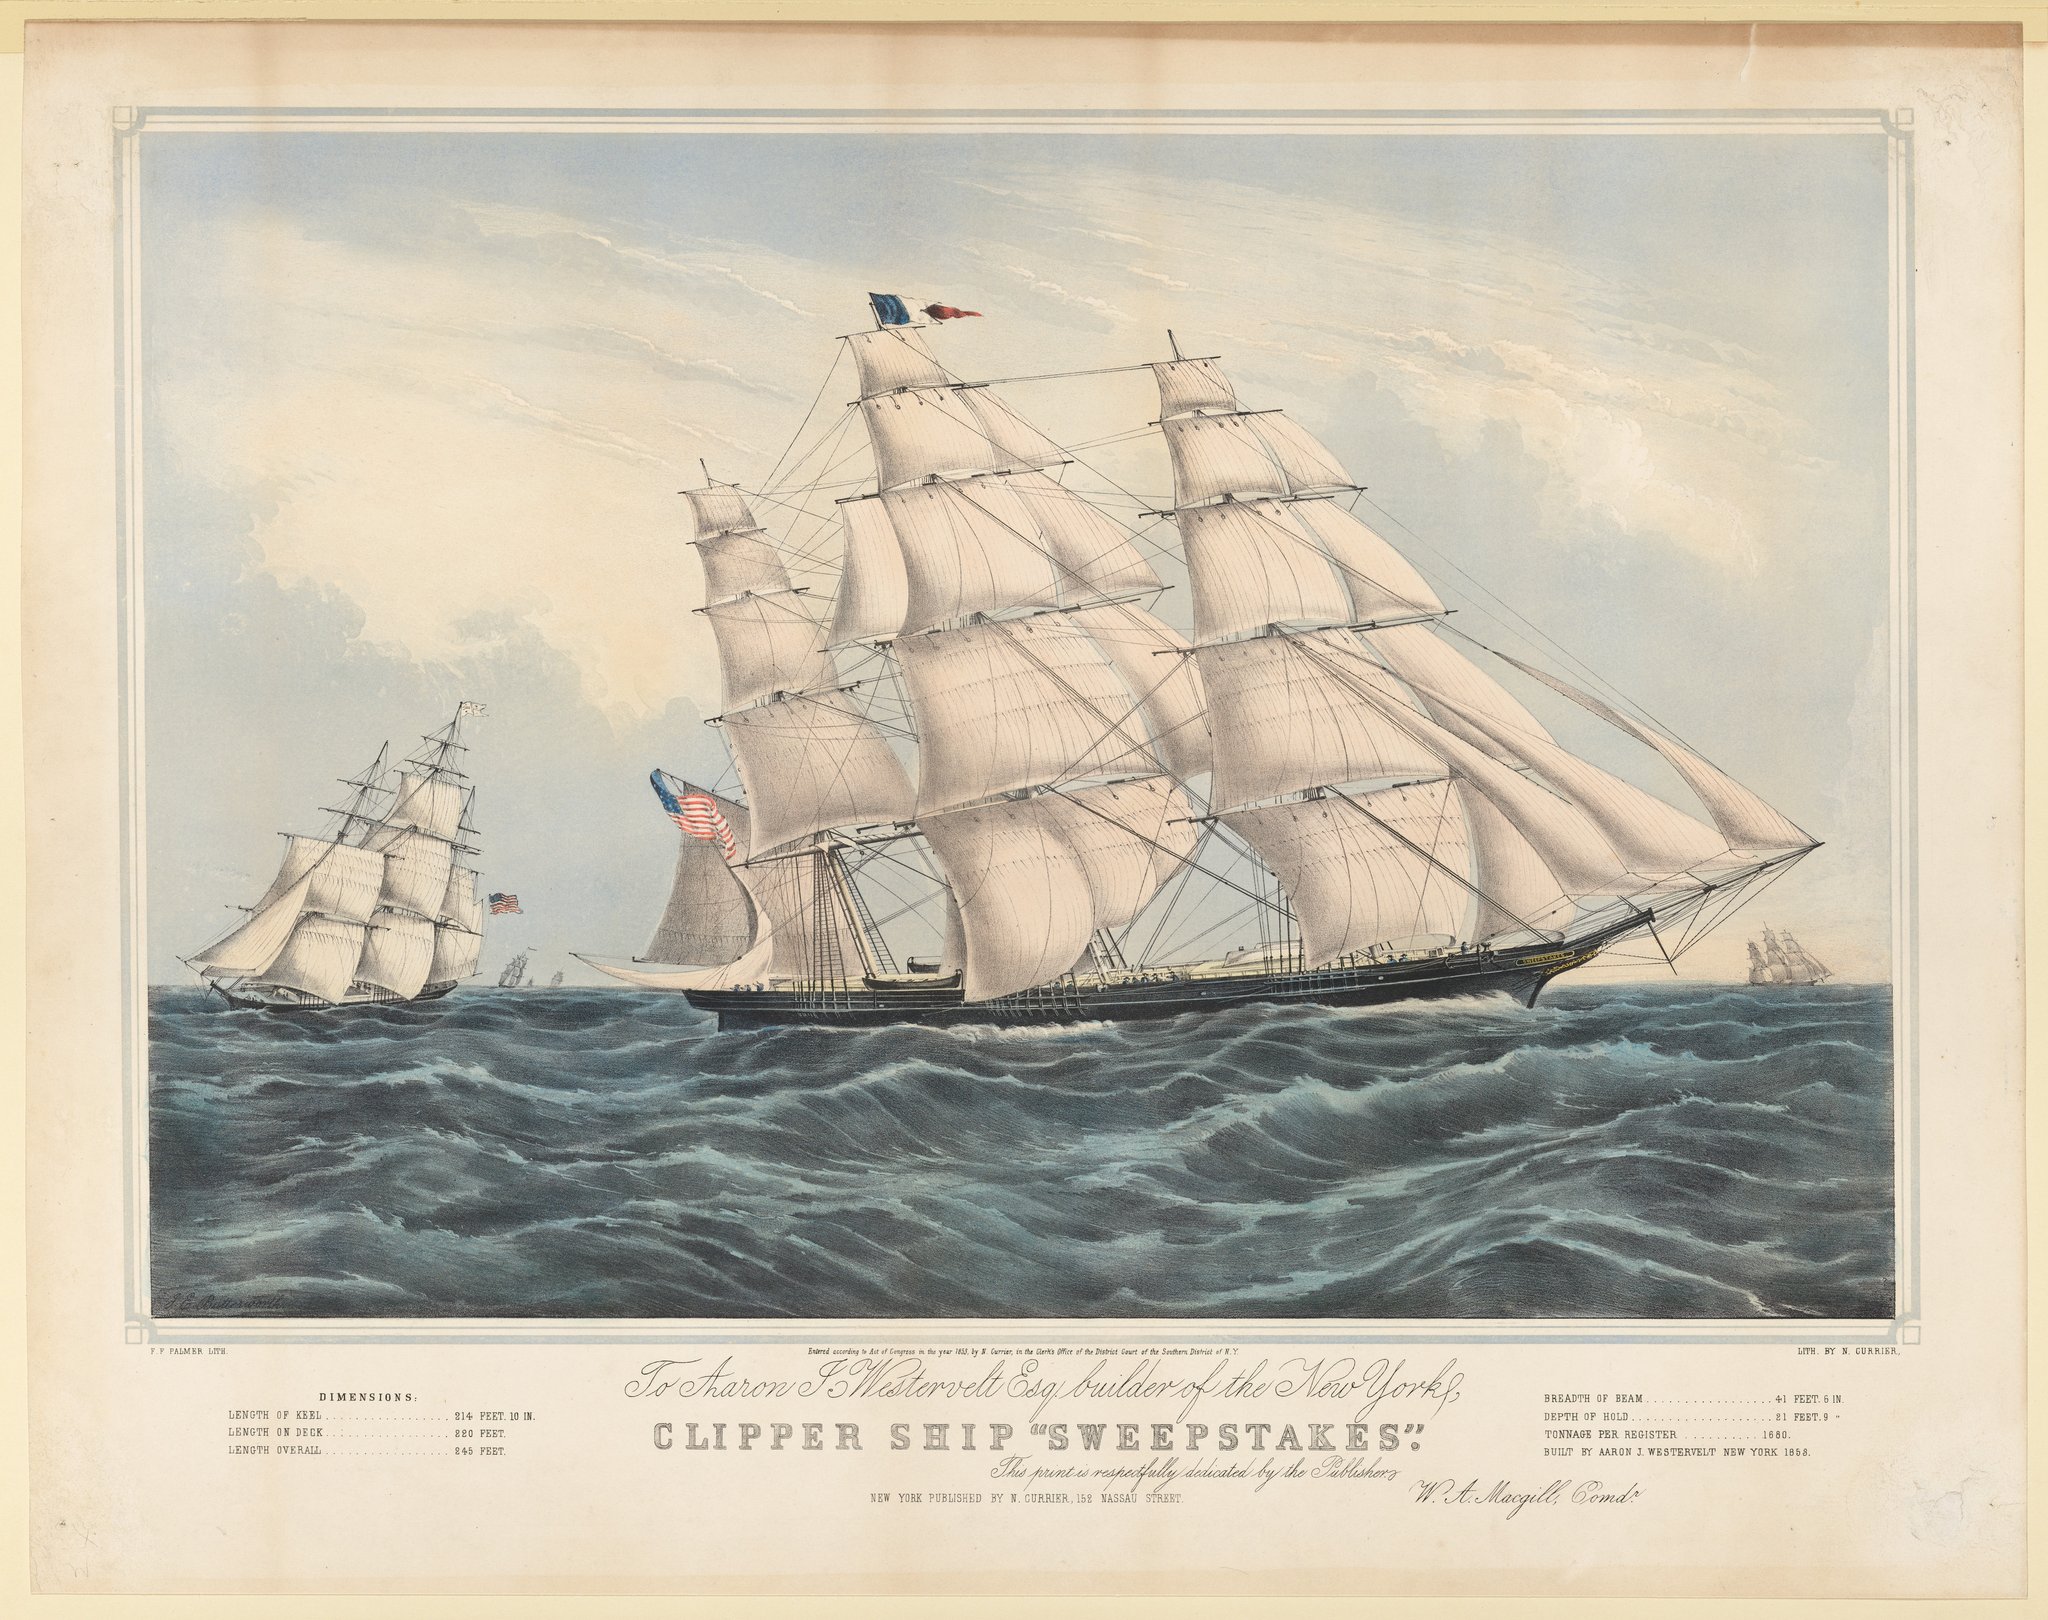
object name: print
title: Clipper Ship "Sweepstakes"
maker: james e. buttersworth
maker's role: artist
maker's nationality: american, born england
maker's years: 1817-1894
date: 1853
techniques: hand coloring, lithograph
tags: ships